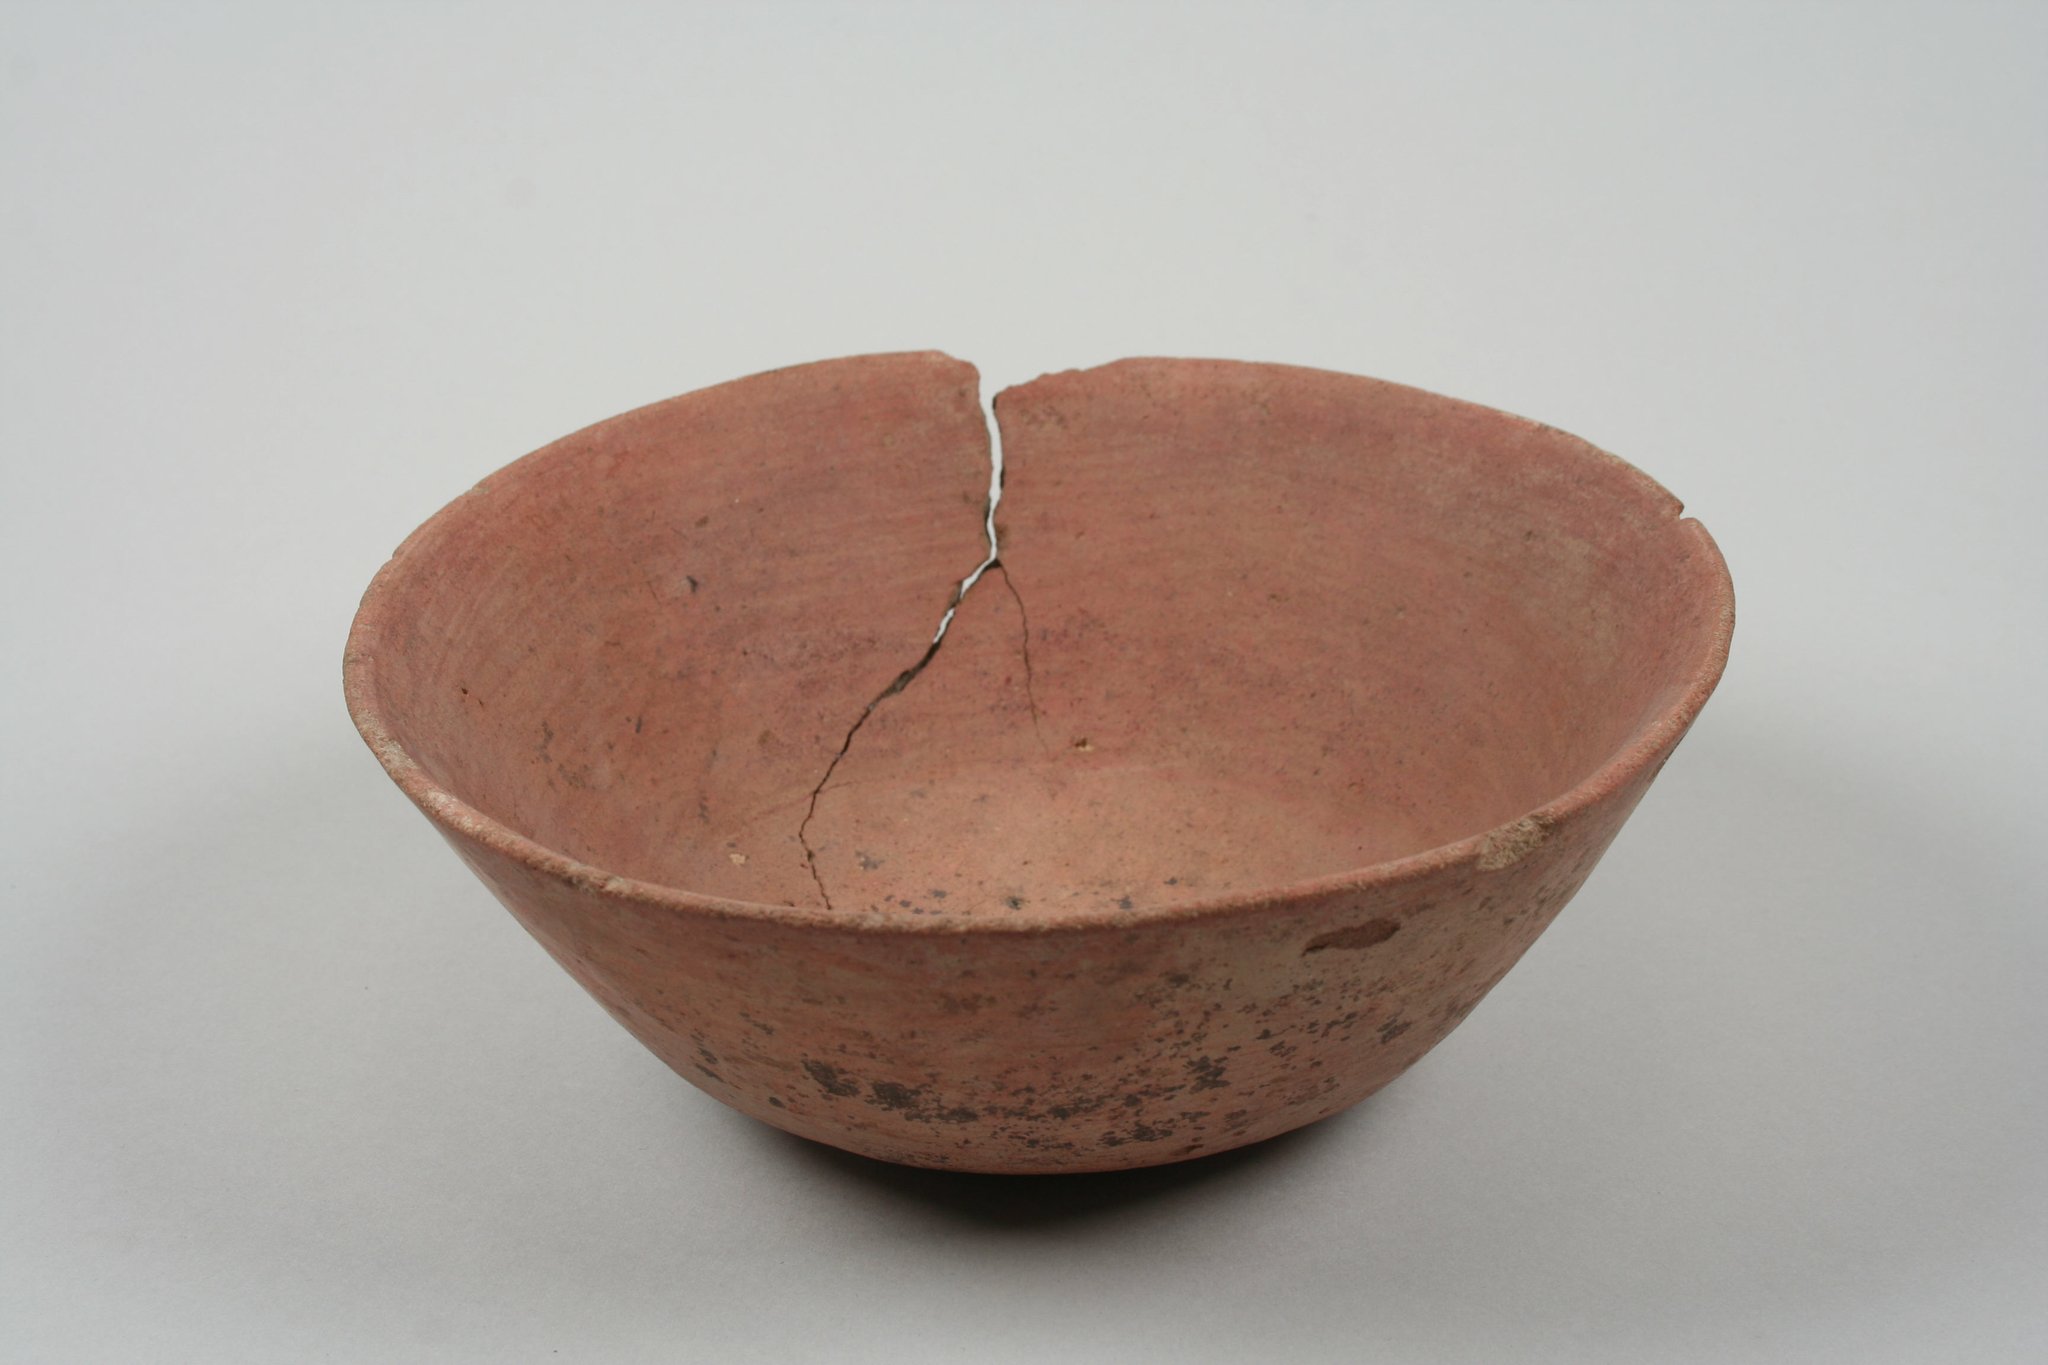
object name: bowl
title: Undecorated painted bowl with flared sides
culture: paracas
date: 600-201 BCE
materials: ceramic, pigment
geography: peru